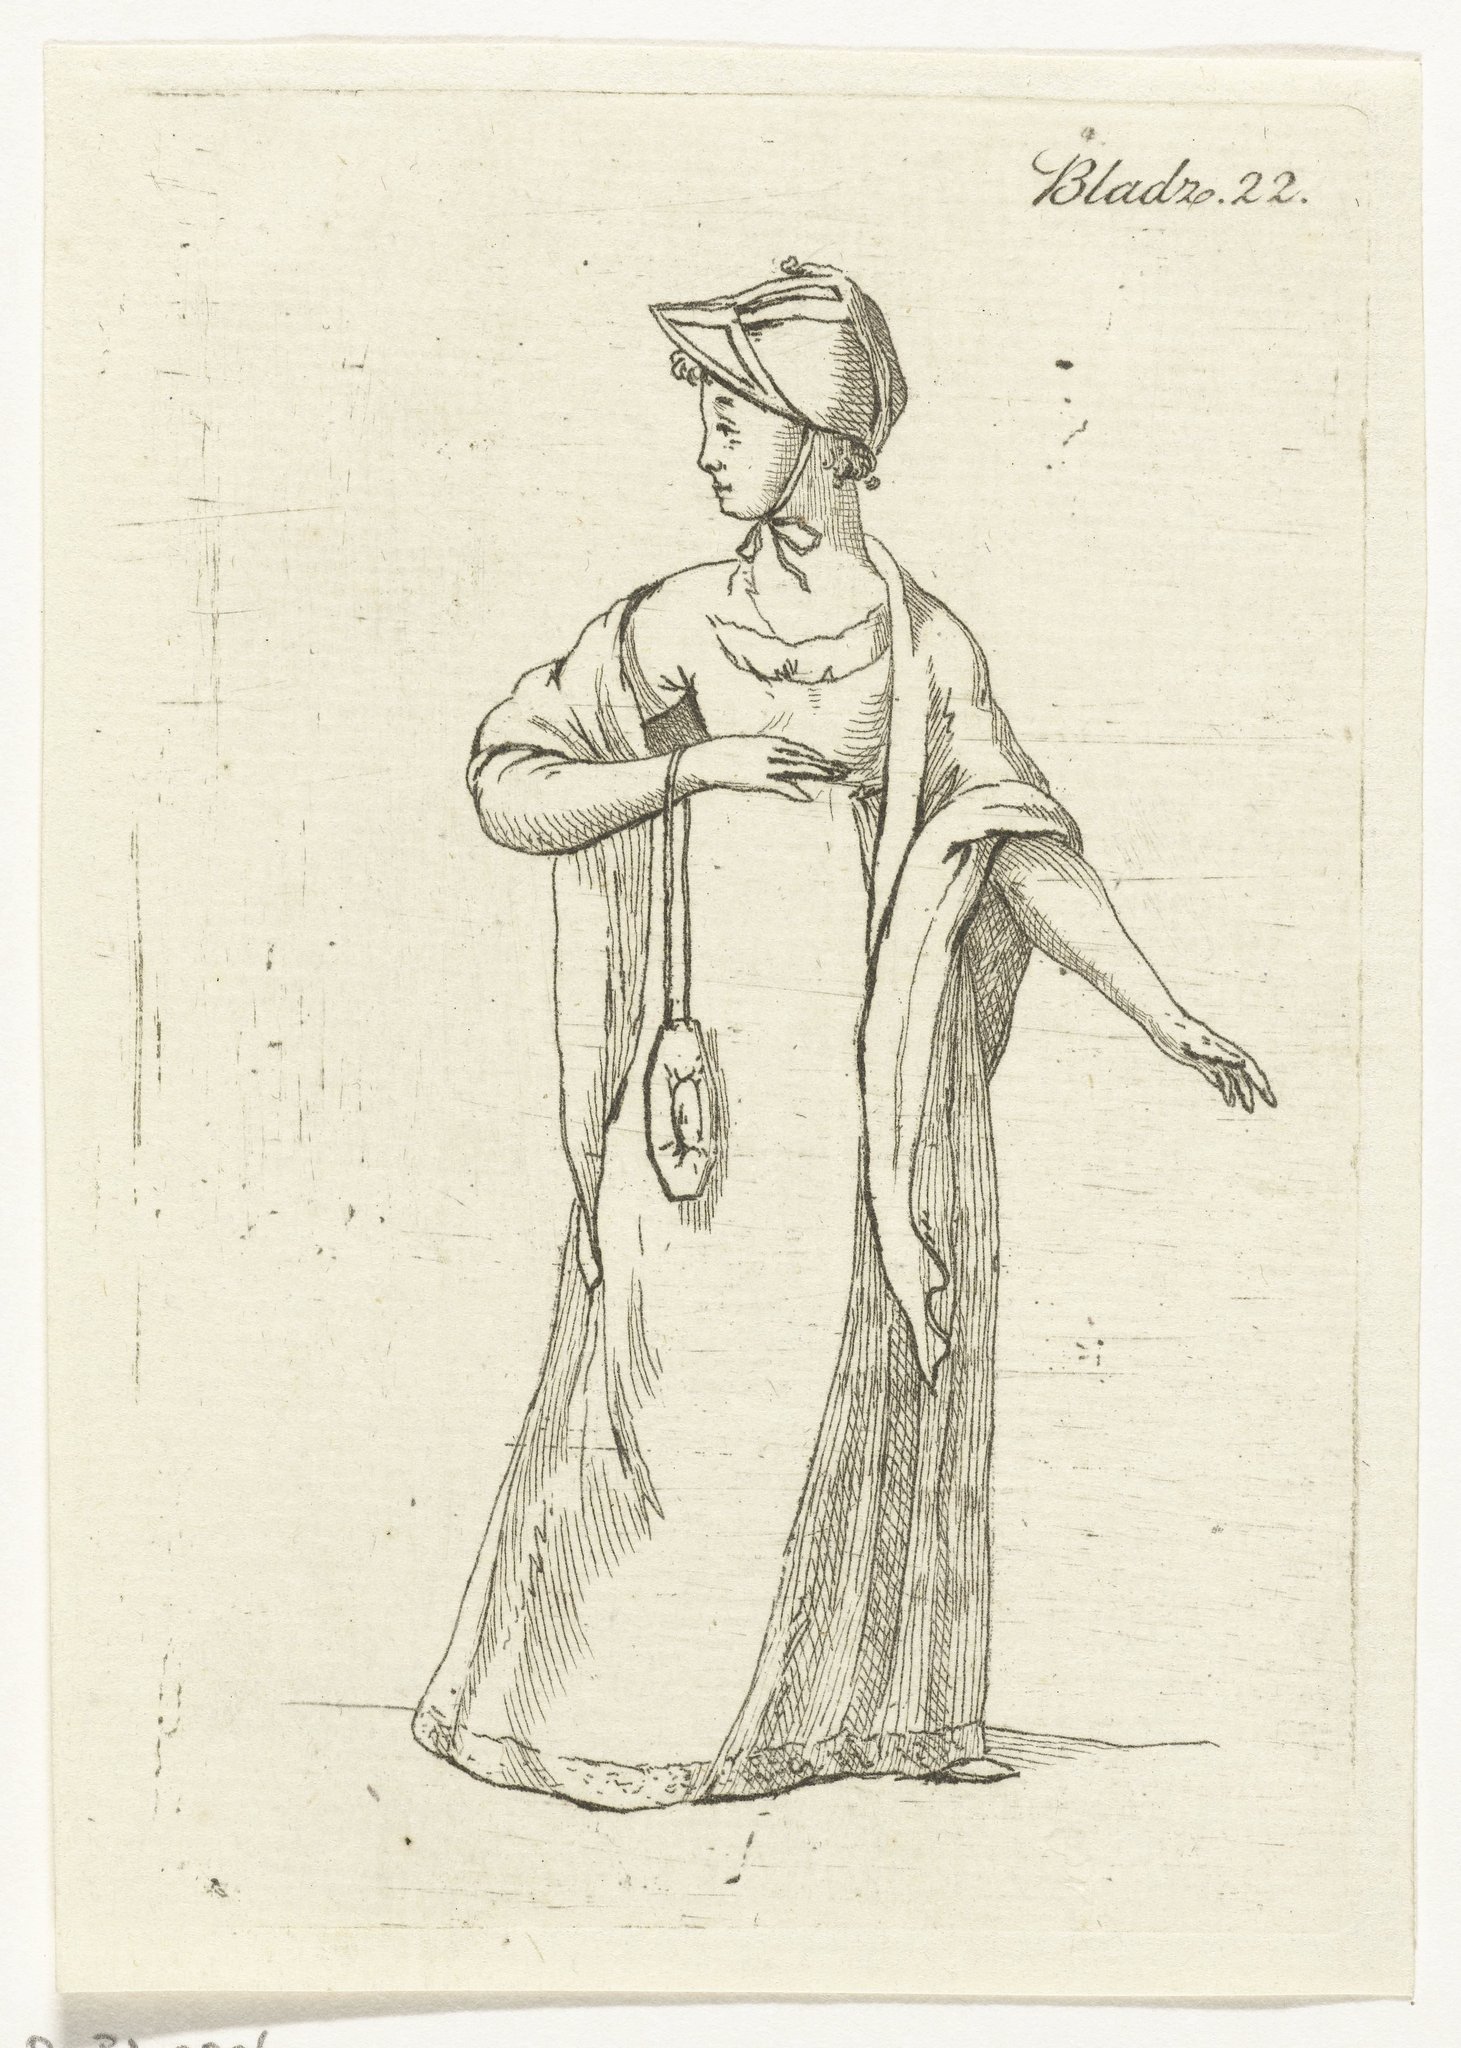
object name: print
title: Staande vrouw met hoed en omslagdoek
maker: anthonie van den bos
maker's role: draughtsman, print maker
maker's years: 1763-1838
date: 1778-1838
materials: paper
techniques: etching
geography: netherlands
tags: standing figure (canon, proportions) - aa - female human figure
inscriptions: collector's mark: Lugt 2228